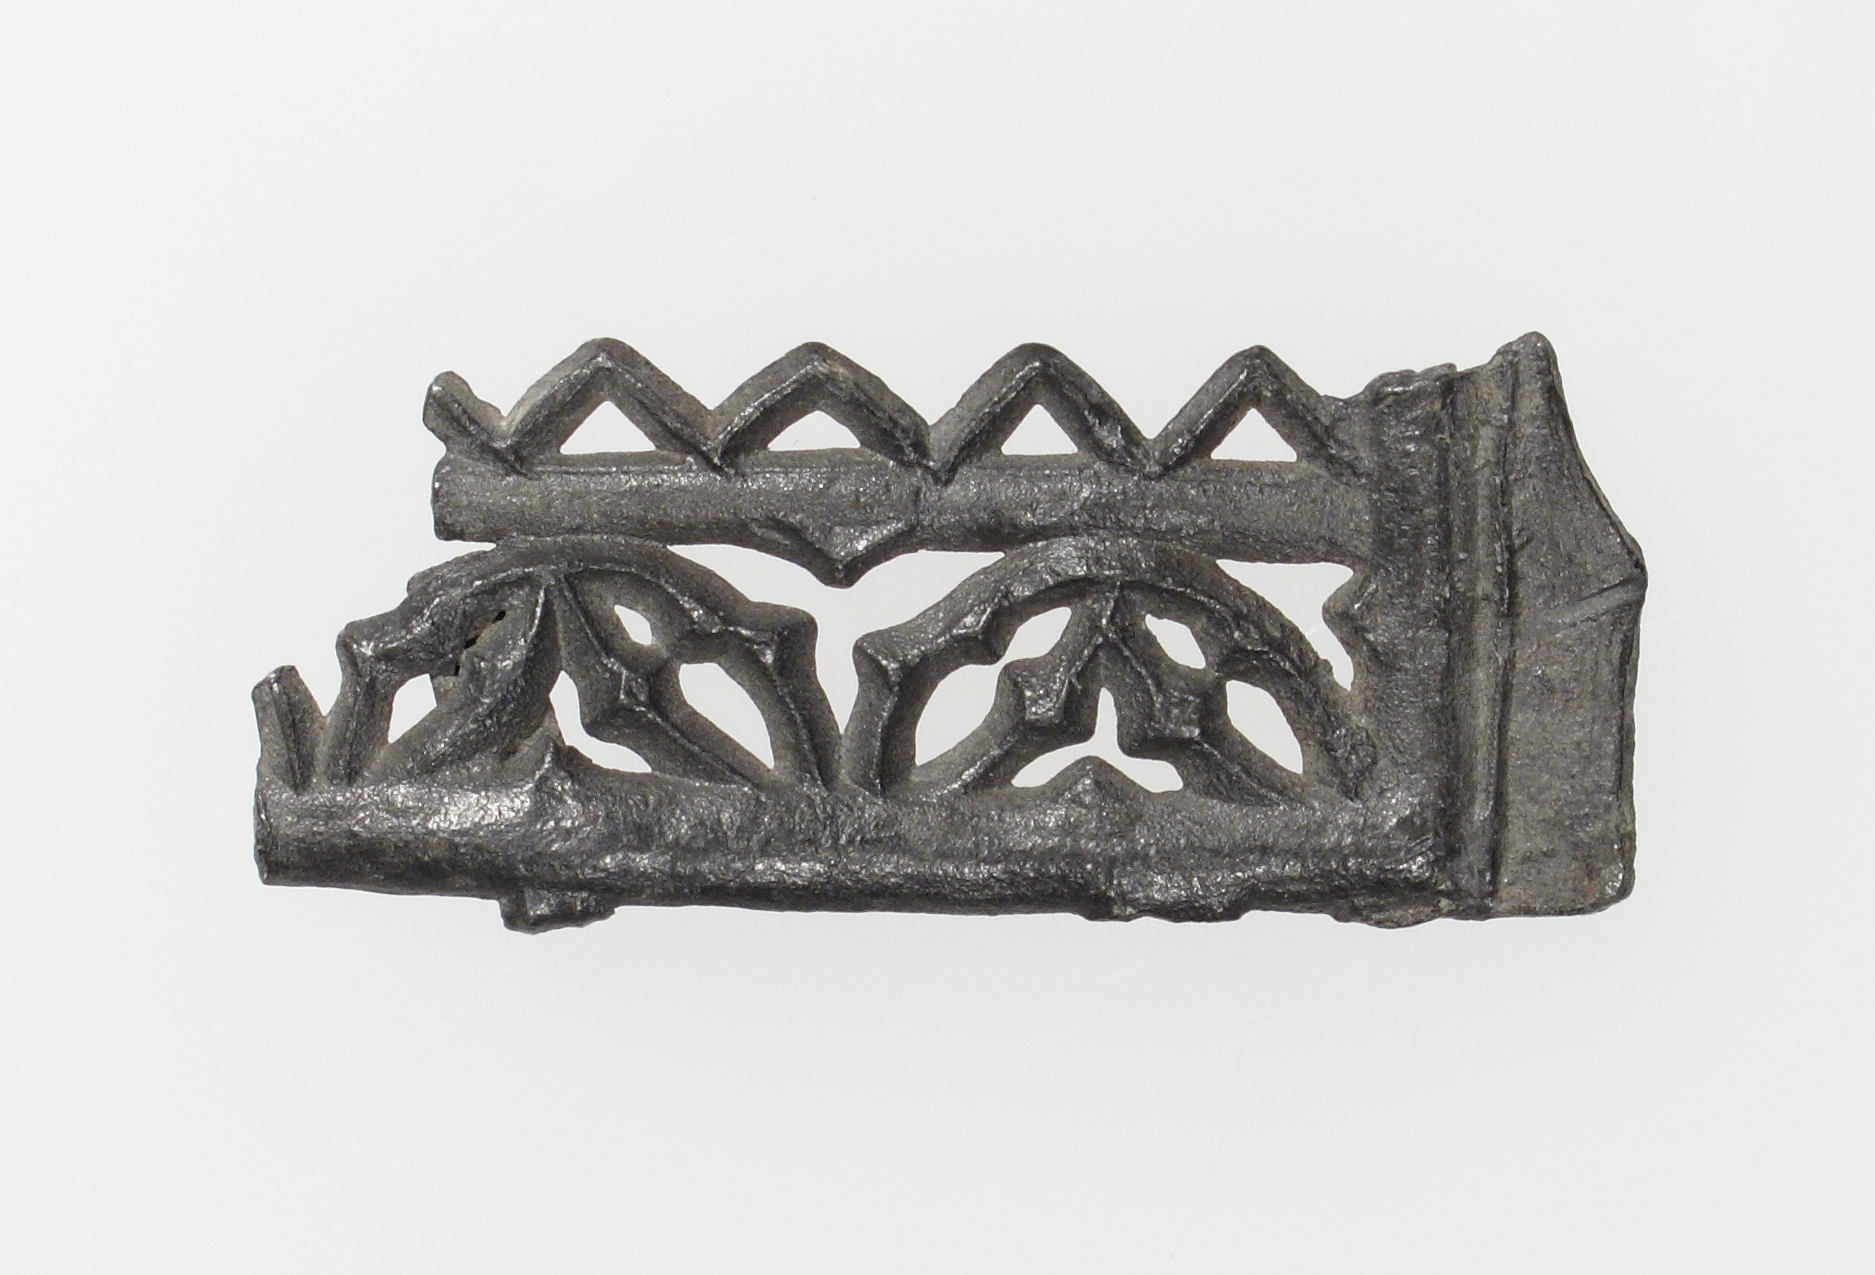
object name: pilgrim's badge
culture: french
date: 1301-1600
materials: lead